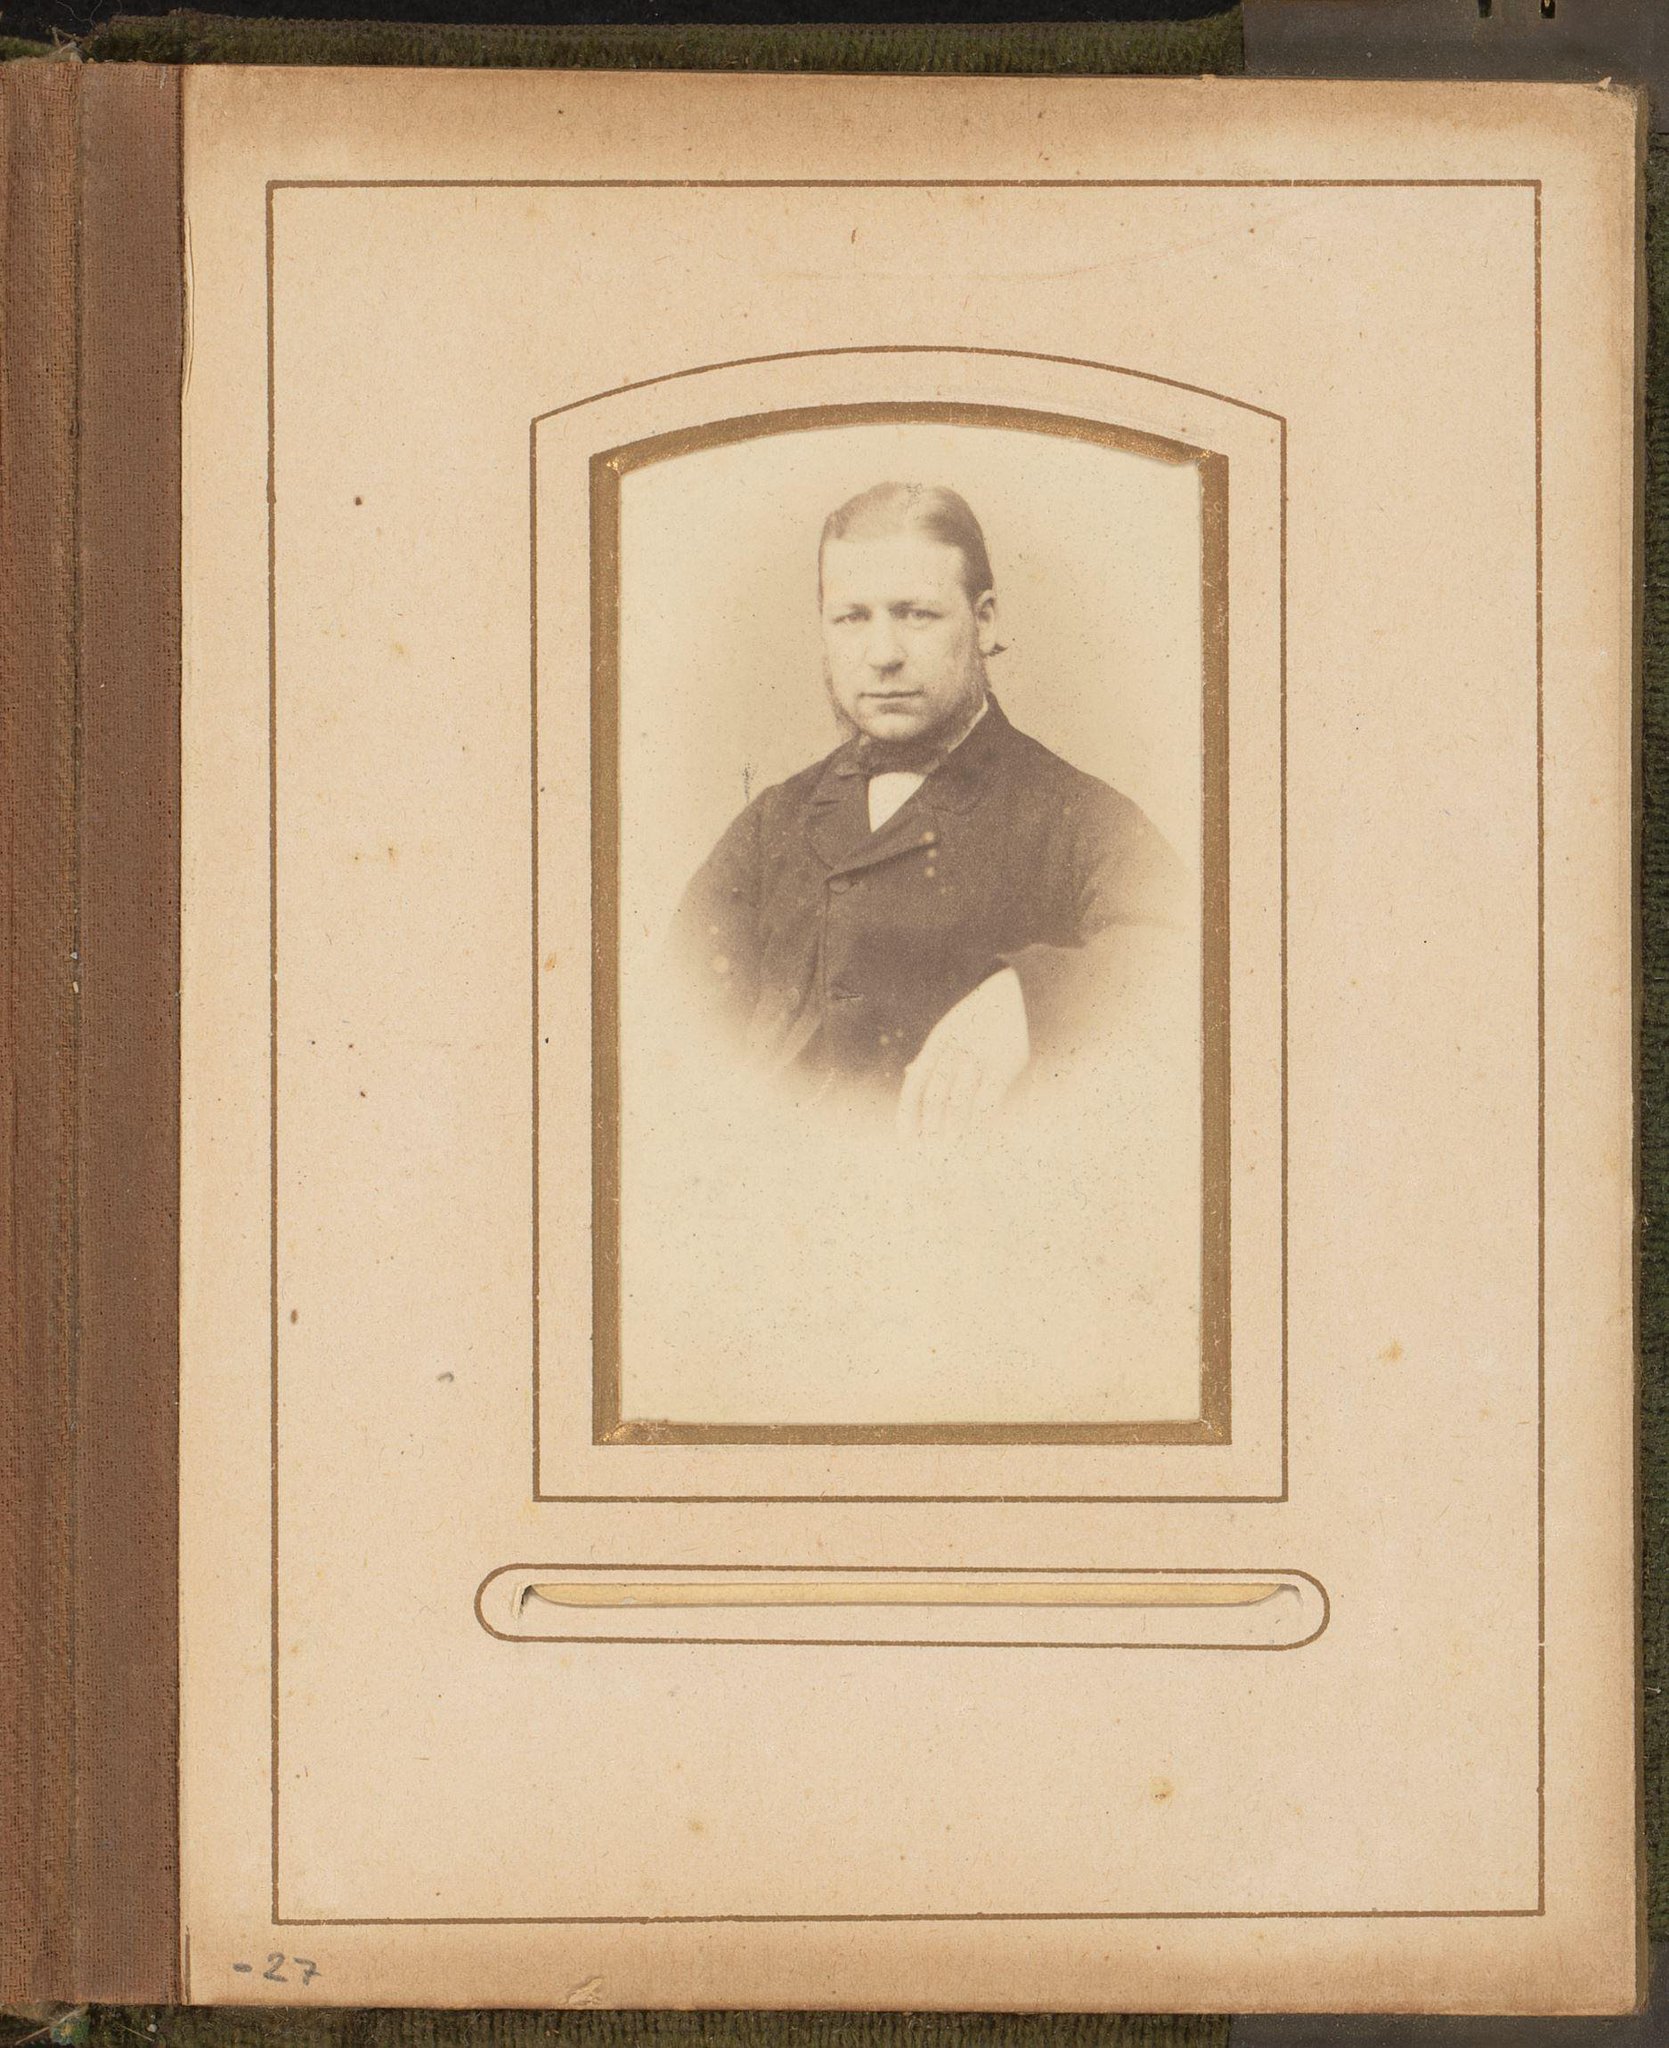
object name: carte de visite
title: Portret van een man, mogelijk lid van de familie Beucker Andreae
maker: Anonymous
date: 1854-1885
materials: cardboard, paper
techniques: albumen print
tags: adult man, anonymous historical person portrayed